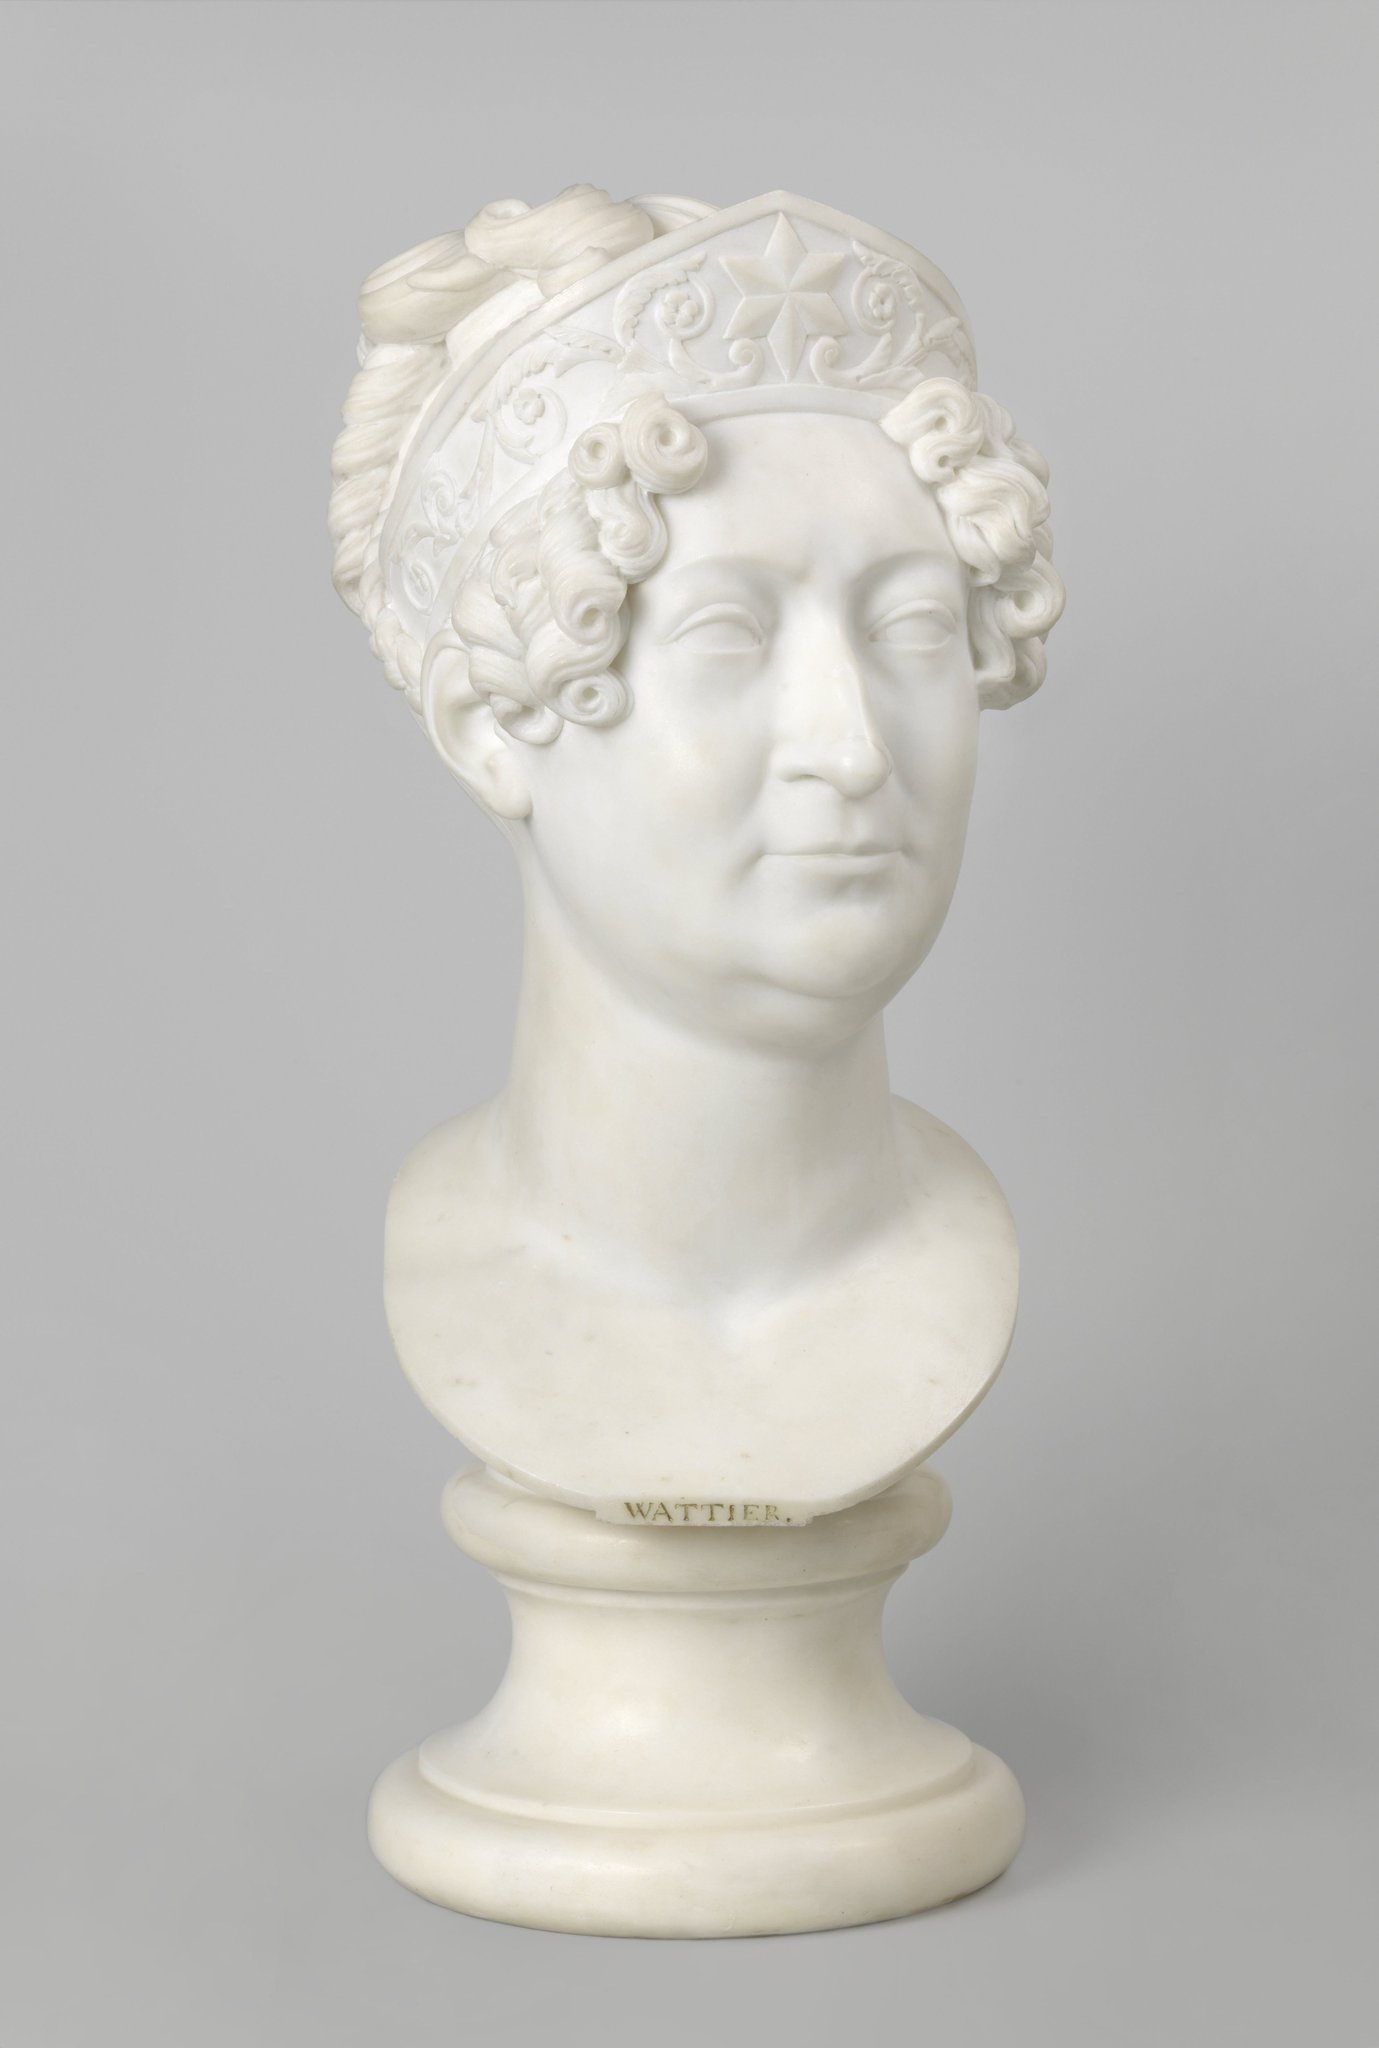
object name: sculpture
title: Portrait of Johanna Cornelia Ziesenis-Wattier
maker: paulus joseph gabriël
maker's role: painter, sculptor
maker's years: 1784-1834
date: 1820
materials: marble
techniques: carved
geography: amsterdam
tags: rotterdam, voorburg, historical persons - bb - woman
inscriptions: signature: ‘WATTIER.’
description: The Dutch actress Johanna Wattier was a true diva in her time, renowned for her interpretation of French theatrical roles. Accordingly, Gabriël gave her a self-possessed, almost regal air in this portrait bust. He derived his inspiration from portraits of Napoleon’s mother and sister by his famous teacher, Canova.